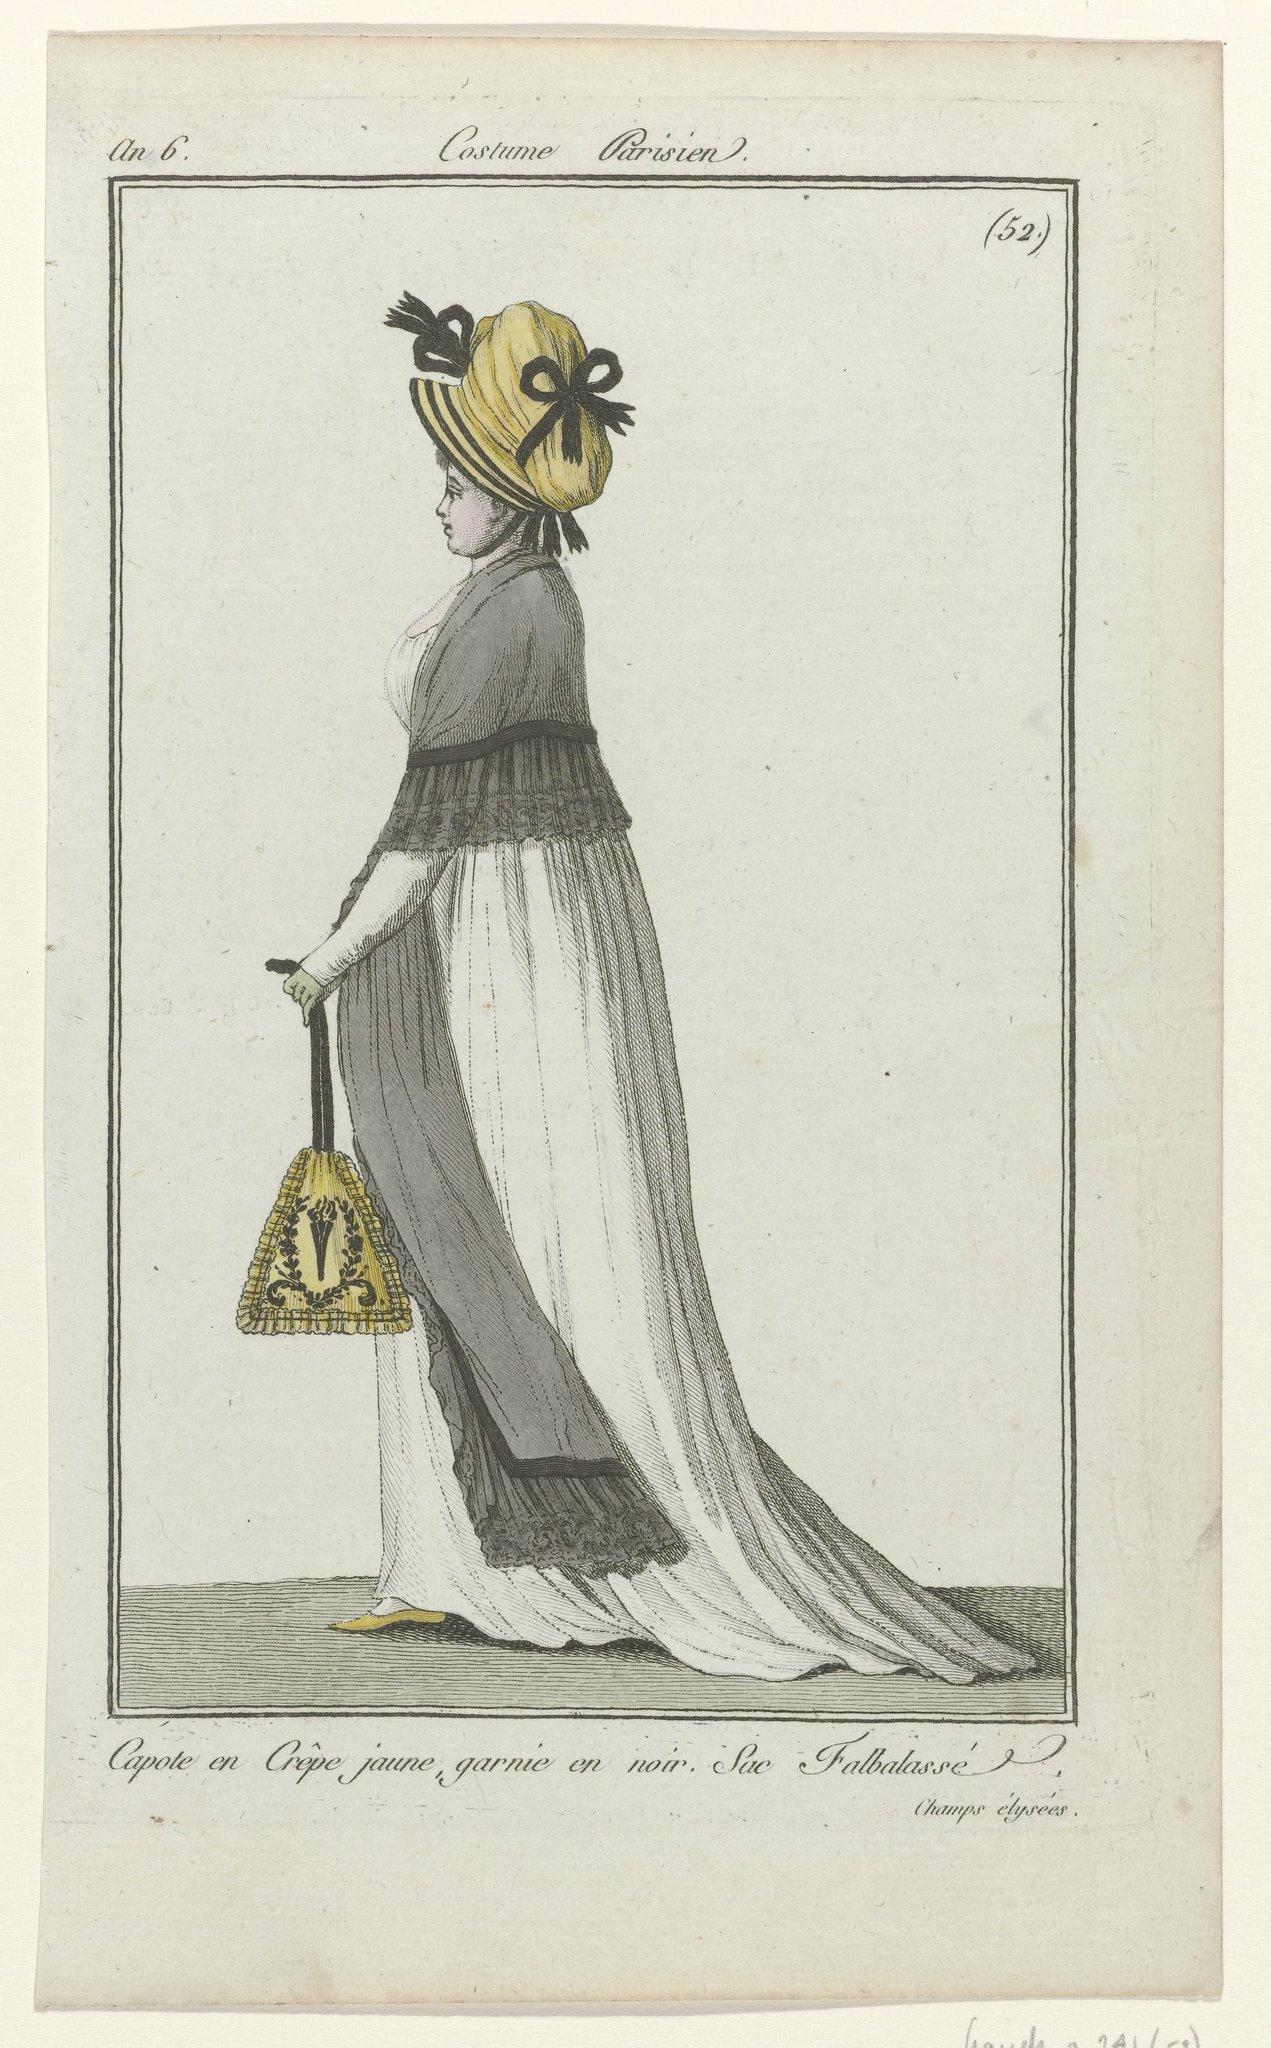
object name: fashion print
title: Journal des Dames et des Modes, Costume Parisien, 28 juillet 1798, An 6, (52) : Capote en Crêp (...)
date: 1798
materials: paper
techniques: engraving, hand coloring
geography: paris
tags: head-gear (capote) (+ women's clothes), bag (handbag) (+ women's clothes), coat (+ women's clothes), fashion plates, shoes, sandals (+ women's clothes), gloves, mittens, etc. (+ women's clothes), dress, gown (+ women's clothes)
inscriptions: caption: ‘Champs élysées.’, caption: ‘Capote en Crêpe jaune, garnie en noir. Sac Falbalassé.’, title: ‘Costume Parisien.’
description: 'Capote' van gele crêpe, afgezet met zwart band. Driehoekig tasje: 'Sac Falbalassé'. Kleine schoudermantel met lange slip op een japon met lange mouwen en sleep. Volgens het onderschrift is deze voorstelling naar het leven getekend op de 'Champs Élysées'. De prent maakt deel uit van het modetijdschrift Journal des Dames et des Modes, uitgegeven door Sellèque, Parijs, 1797-1839.